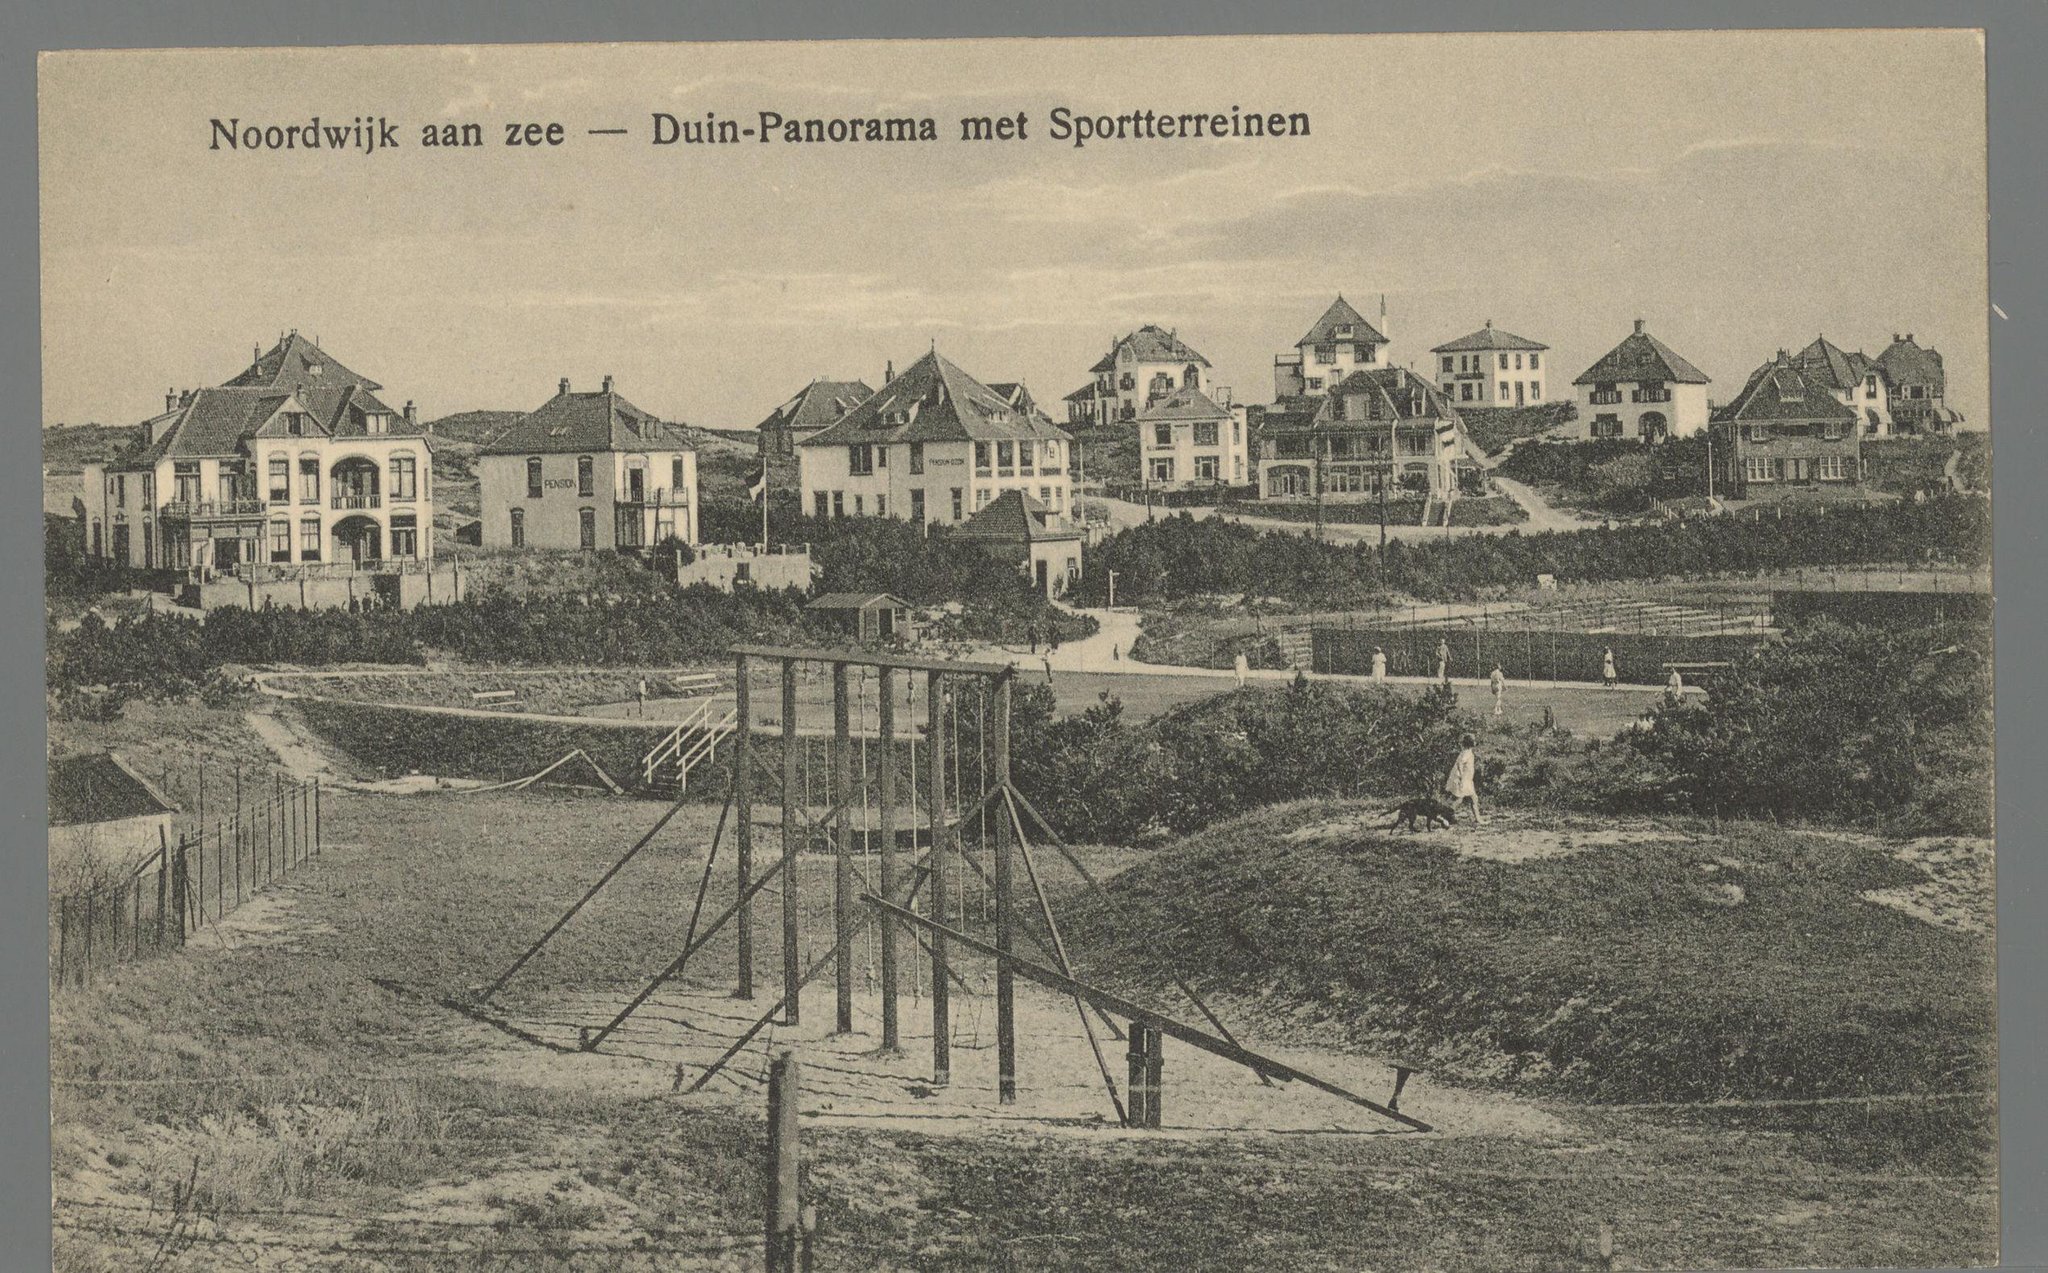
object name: ansichtkaart, prentbriefkaart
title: Noordwijk aan Zee - Duin-panorama met sportterreinen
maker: Anonymous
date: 1905-1930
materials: cardboard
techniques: photograph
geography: noordwijk aan zee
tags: grounds, fields and accomodations for sports, games and physical performances, dunes (sea not visible); in the dunes